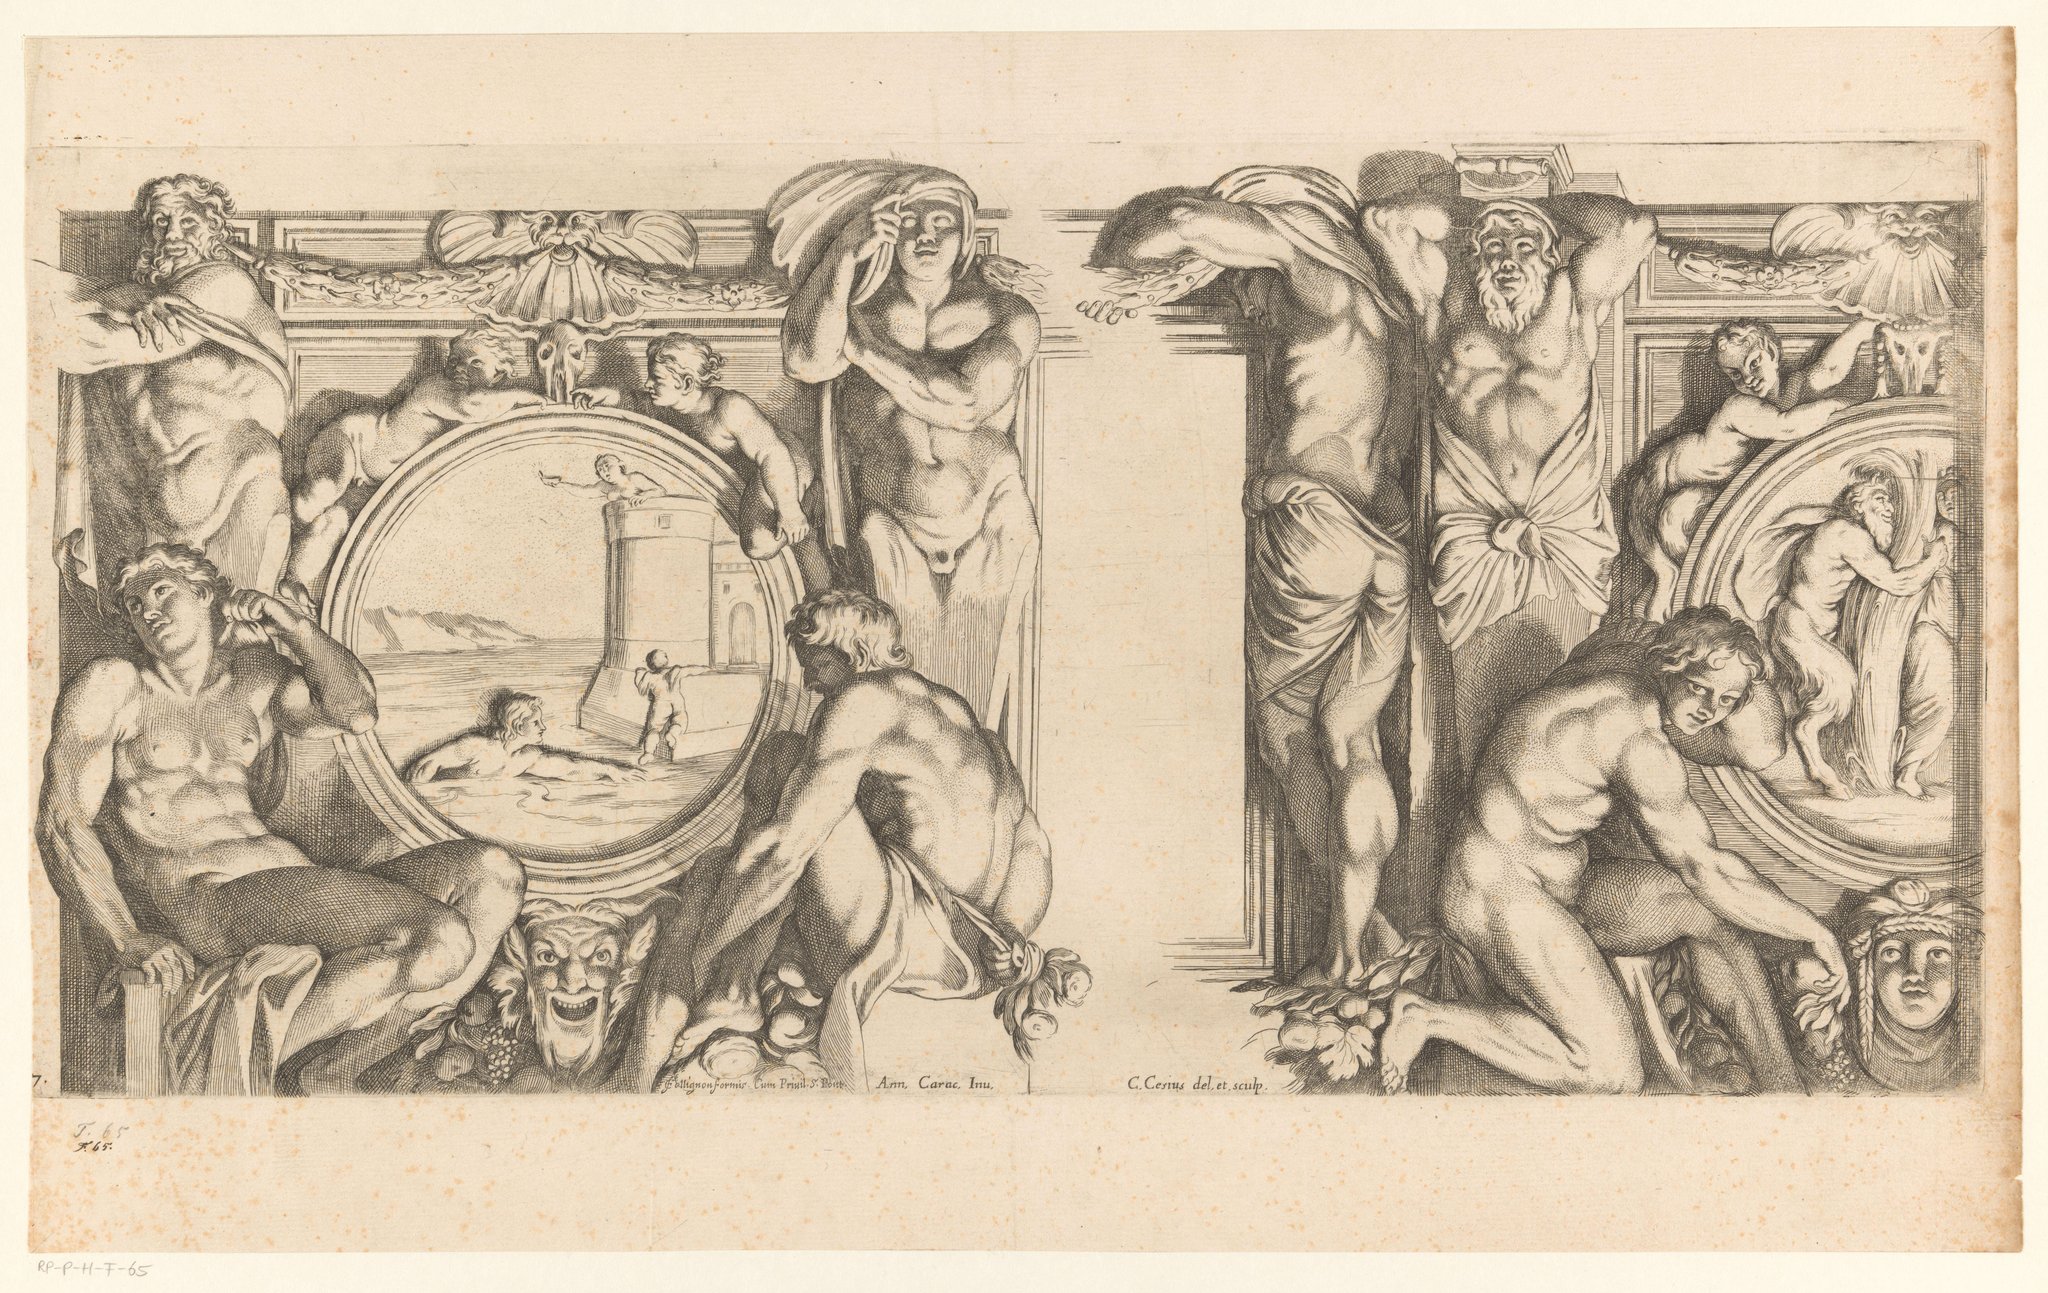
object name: print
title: Leander zwemt naar Hero over de Hellespont / Pan achtervolgt Syrinx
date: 1656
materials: paper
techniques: etching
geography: vatican city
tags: the (nude) human figure; 'corpo humano' (ripa), leander swims across the hellespont at night, usually guided by a torch reared upon a tower by hero, (story of) hero and leander, cupids: 'amores', 'amoretti', 'putti', syrinx changed into a reed: while fleeing from pan, the nymph syrinx is changed into reed by her sisters, the naiads (ovid, metamorphoses i 705)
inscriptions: collector's mark: ‘Hinloopen’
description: Prent uit een reeks prenten met nummers van 1 tot en met 29 (sommige prenten hebben hetzelfde nummer), plus titelprent en opdracht, naar schilderingen in Palazzo Farnese te Rome. Deze prent maakte oorspronkelijk deel uit van liber nr. 22 van de Atlas van Rome, uit de collectie Hinloopen. In dit album waren een aantal prentreeksen naar bekende zeventiende eeuwse frescoseries bijeengebonden. In 1709 heeft Schijnvoet op last van de burgemeesters van Amsterdam de collectie herordend. De prenten uit liber 22 kwamen terrecht in Schijnvoet boek nr. 10. De laatst gedateerde reeks in het album is gedateerd 1691. Het album moet dus na deze datum gebonden zijn. De band is in de Rijksakademietijd uit elkaar gehaald. De marges van de prenten zijn bij het opbergen in het Rijksprentenkabinet vaak drastisch afgesneden. Van een aantal series waren de prenten teruggeslagen om in het album te passen. (Zie: Waals, Jan van der. De prentschat van Michiel Hinloopen. 's-Gravenhage: SDU uitgeverij, 1988, pp. 173-174.)